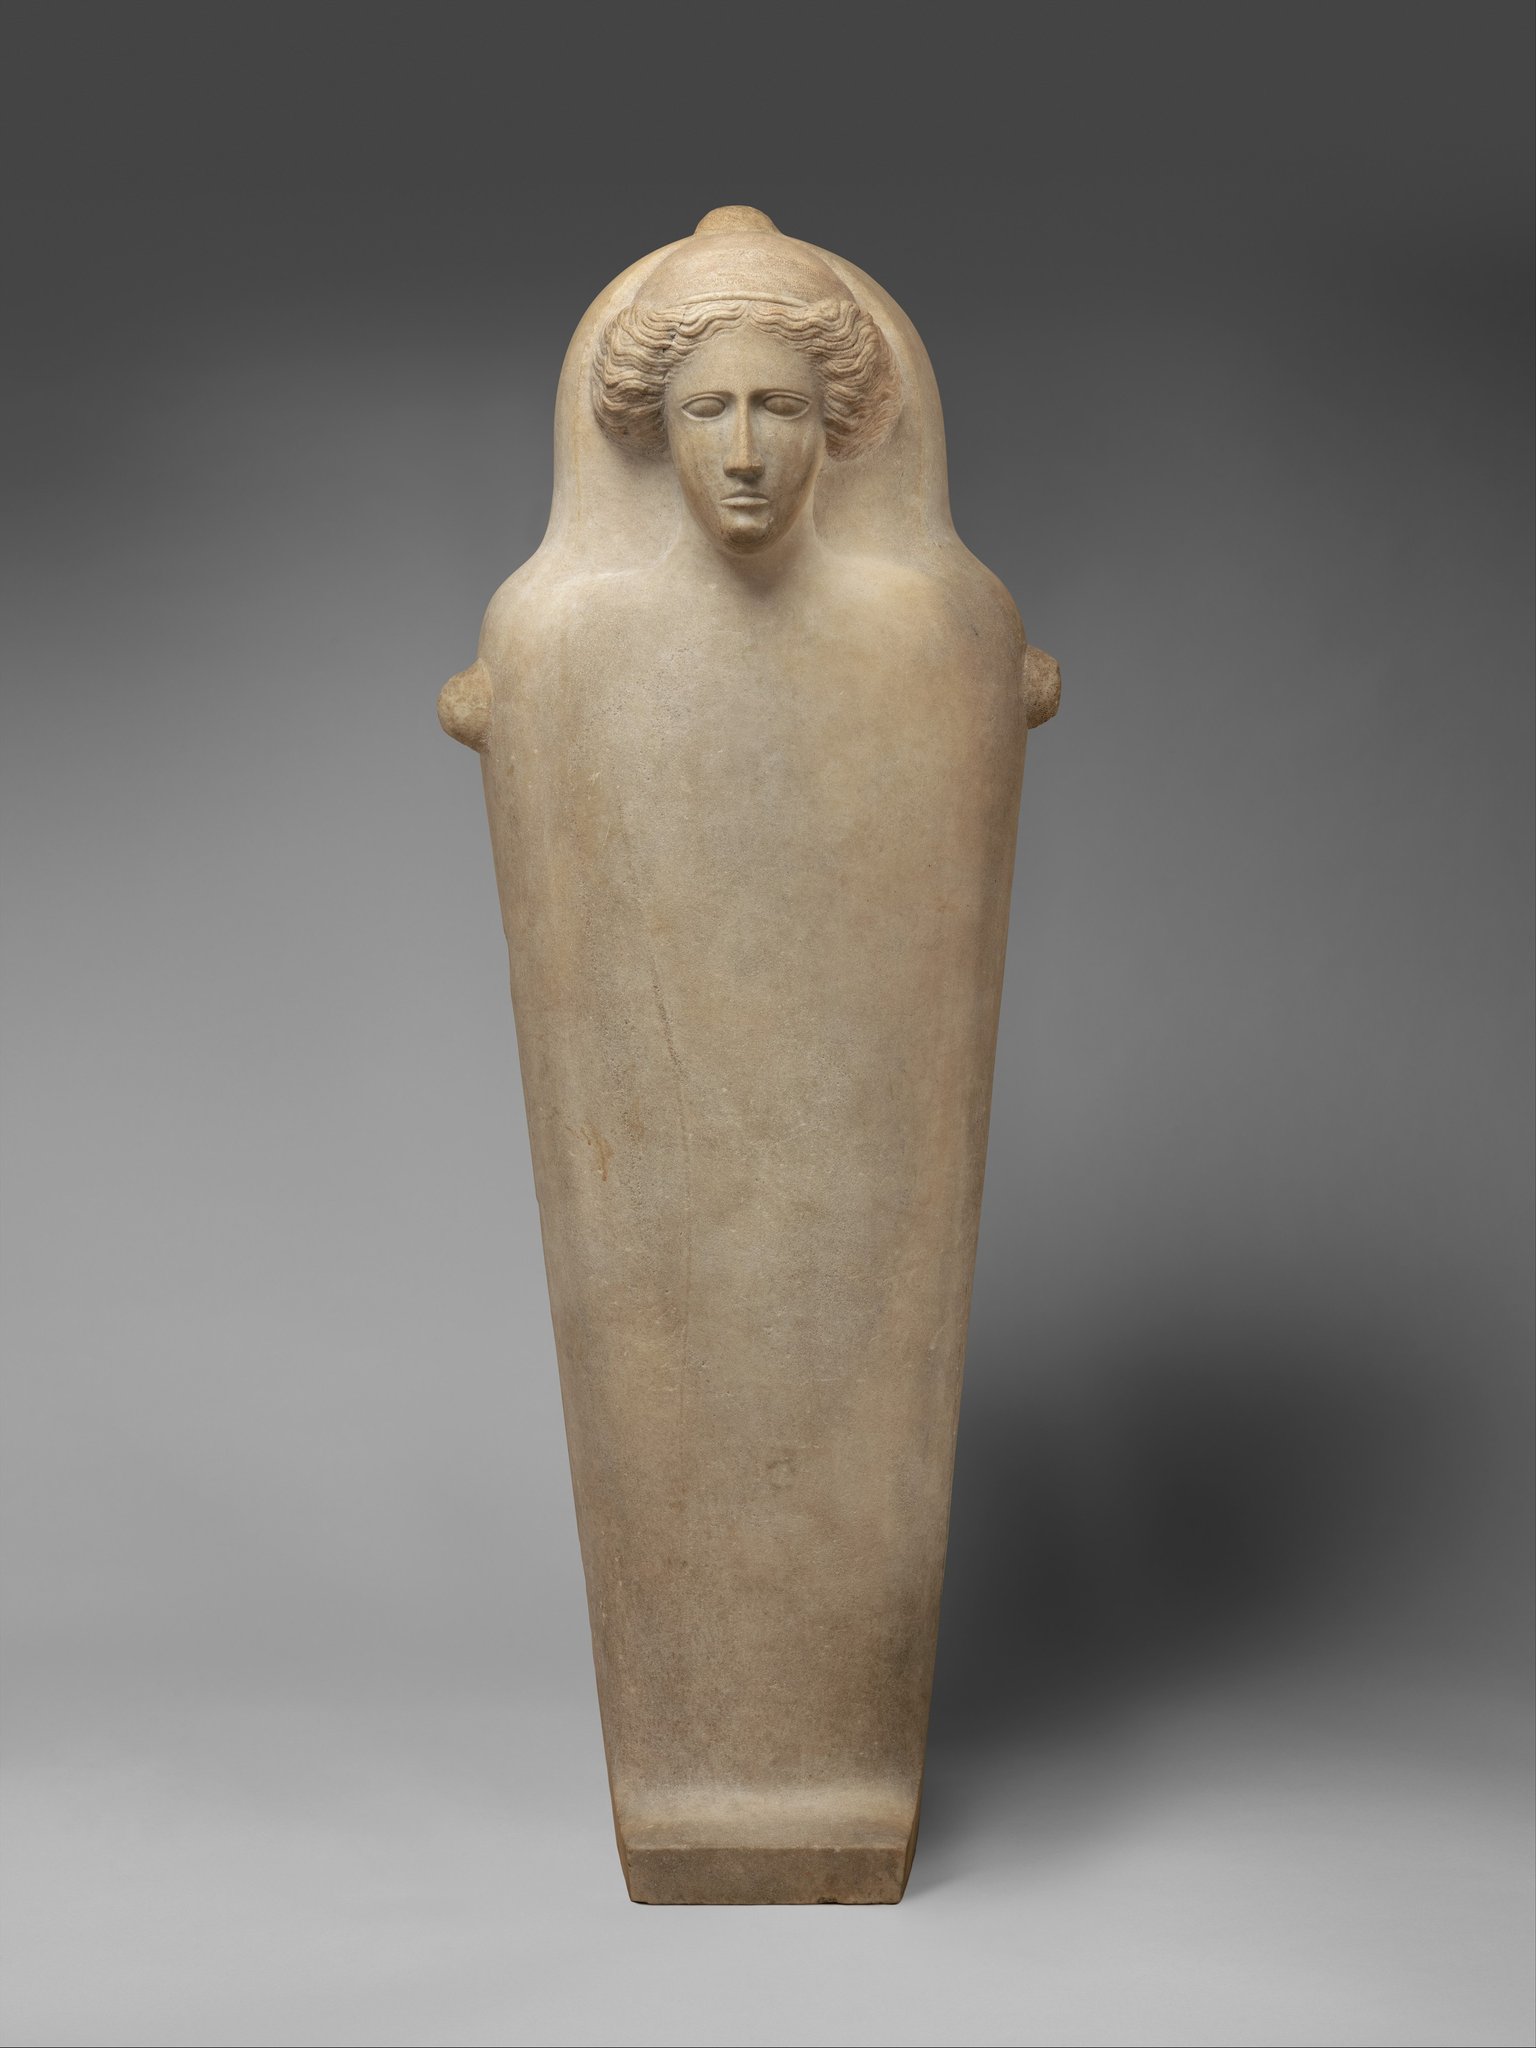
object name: sarcophagus, anthropoid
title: Marble anthropoid sarcophagus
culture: graeco-phoenician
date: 425-401 BCE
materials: marble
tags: women